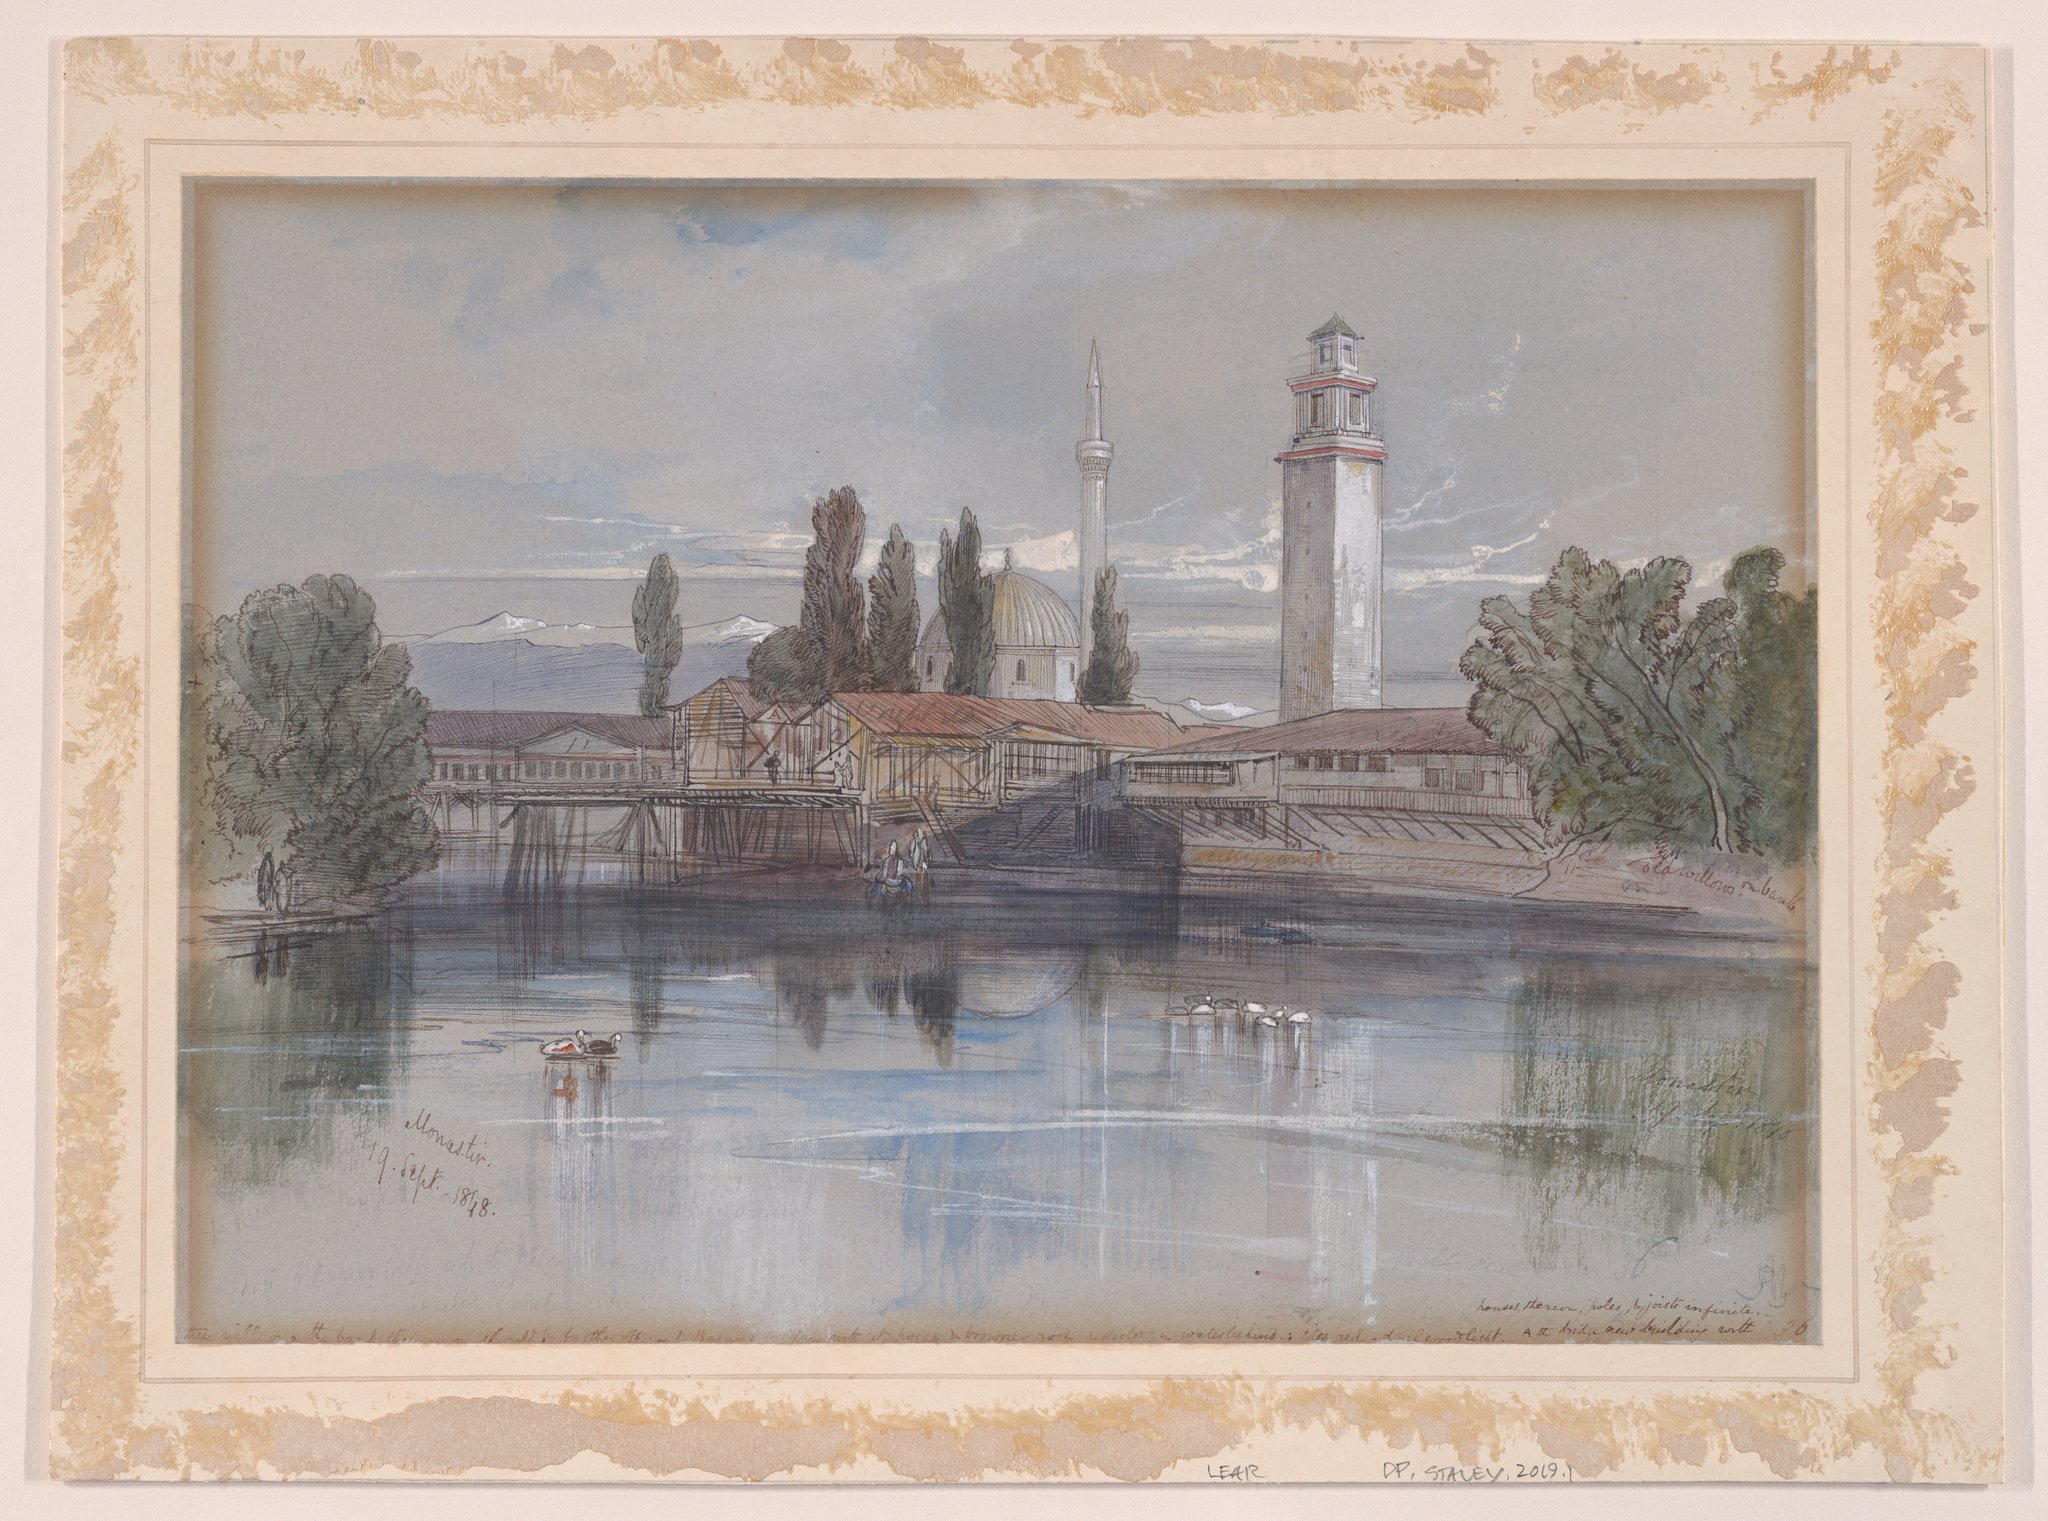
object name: drawing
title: Monastir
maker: edward lear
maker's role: artist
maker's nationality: british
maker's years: 1812-1888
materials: ink, paper, watercolor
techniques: pen